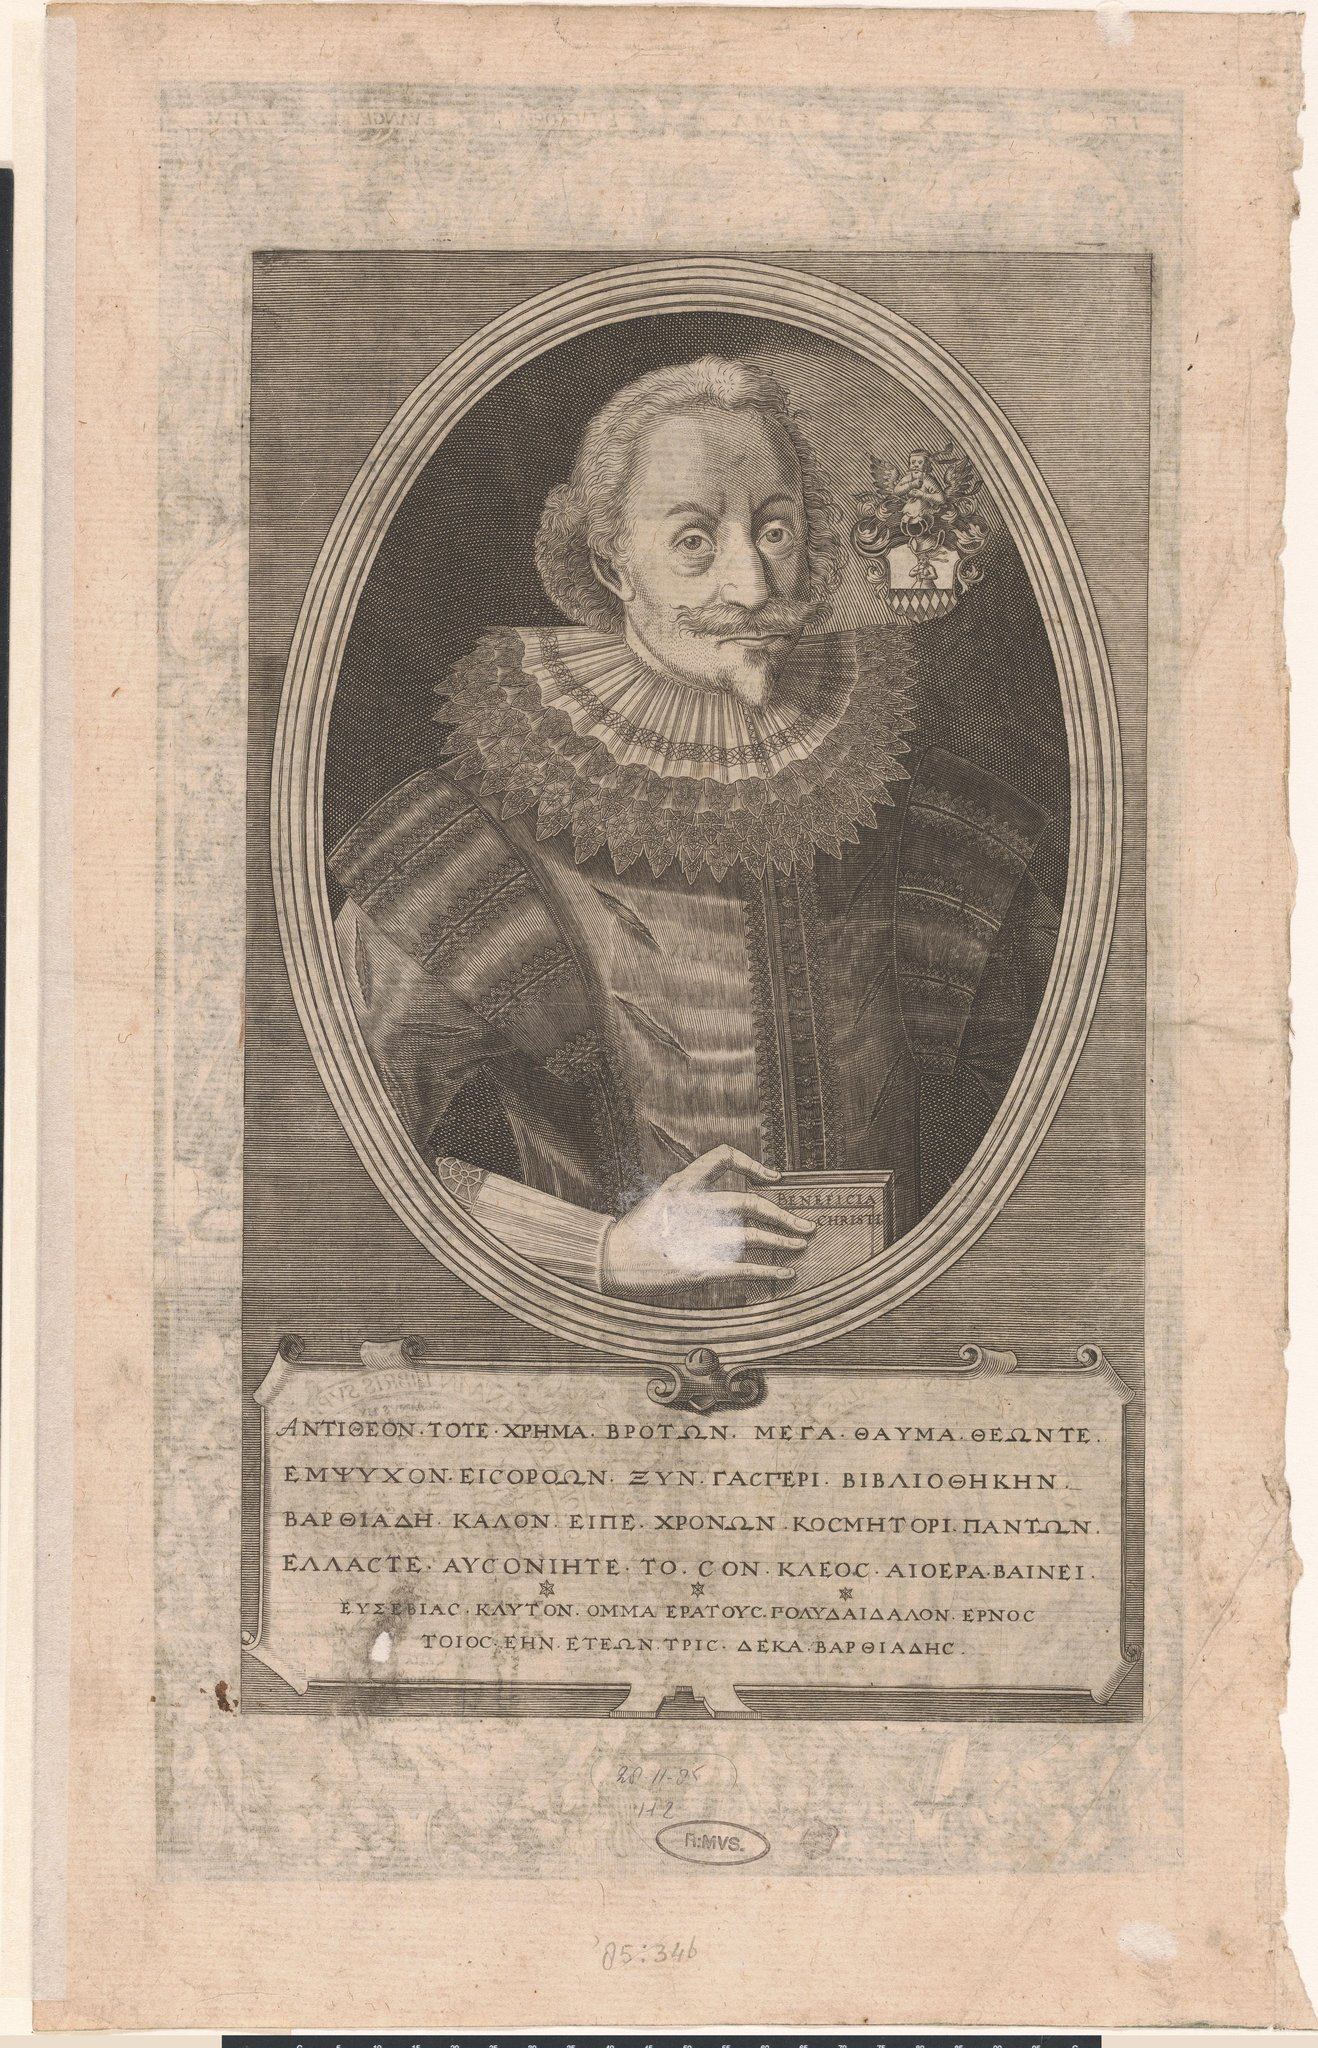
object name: print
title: Portret van Caspar von Barth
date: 1624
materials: paper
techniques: engraving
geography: frankfurt am main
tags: caspar von barth, portrait of a writer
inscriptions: collector's mark: Lugt 2228, collector's mark: Lugt 2760, inscription: ‘28-11-85 / 1+2’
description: Ovaal medaillon met portret van schrijver Caspar von Barth met boek in zijn hand. Aan de onderzijde een tablet met zevenregelige Griekse tekst.